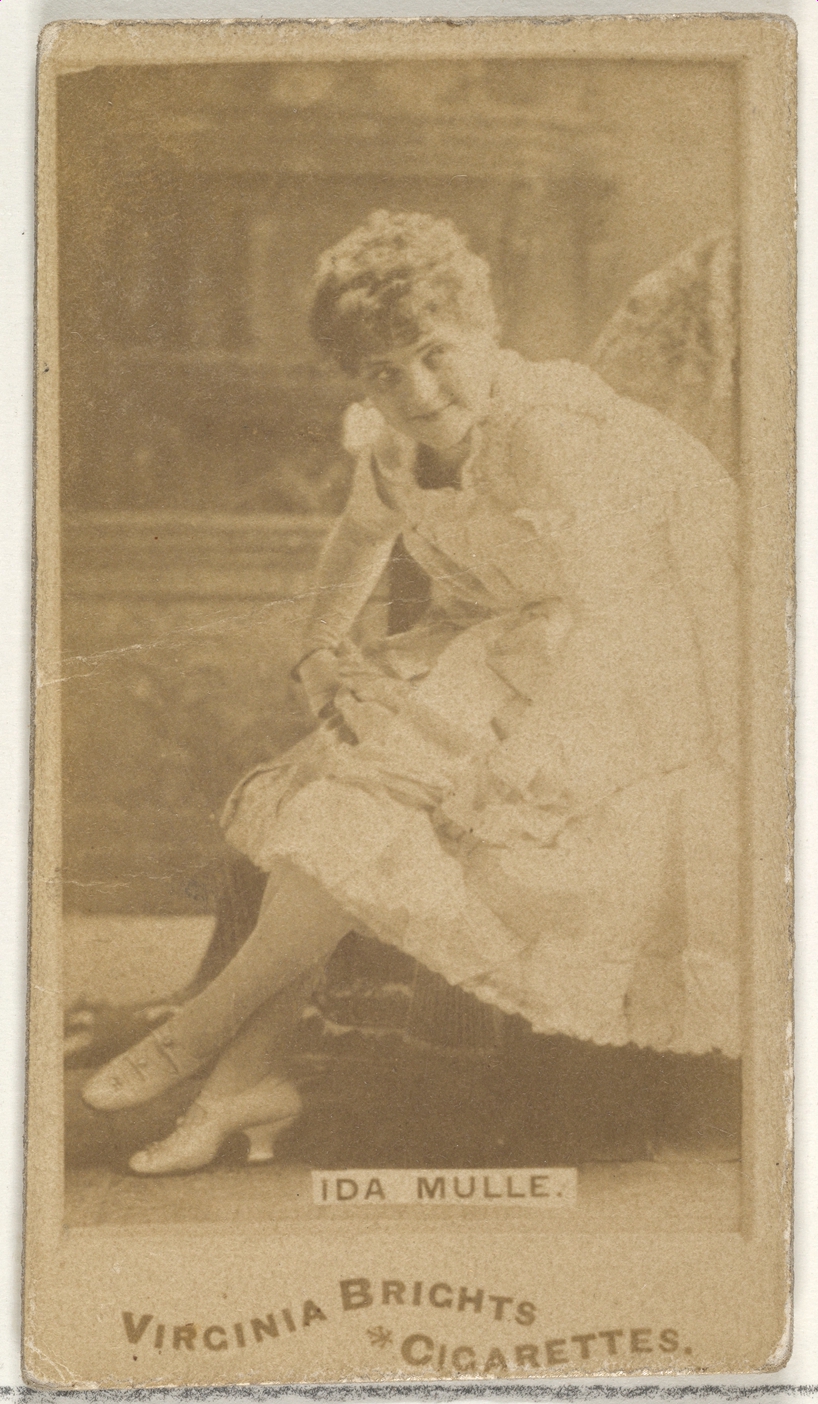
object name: photograph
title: Ida Mulle, from the Actors and Actresses series (N45, Type 1) for Virginia Brights Cigarettes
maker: allen & ginter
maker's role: publisher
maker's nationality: american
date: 1888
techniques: albumen silver print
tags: portraits,women,actresses